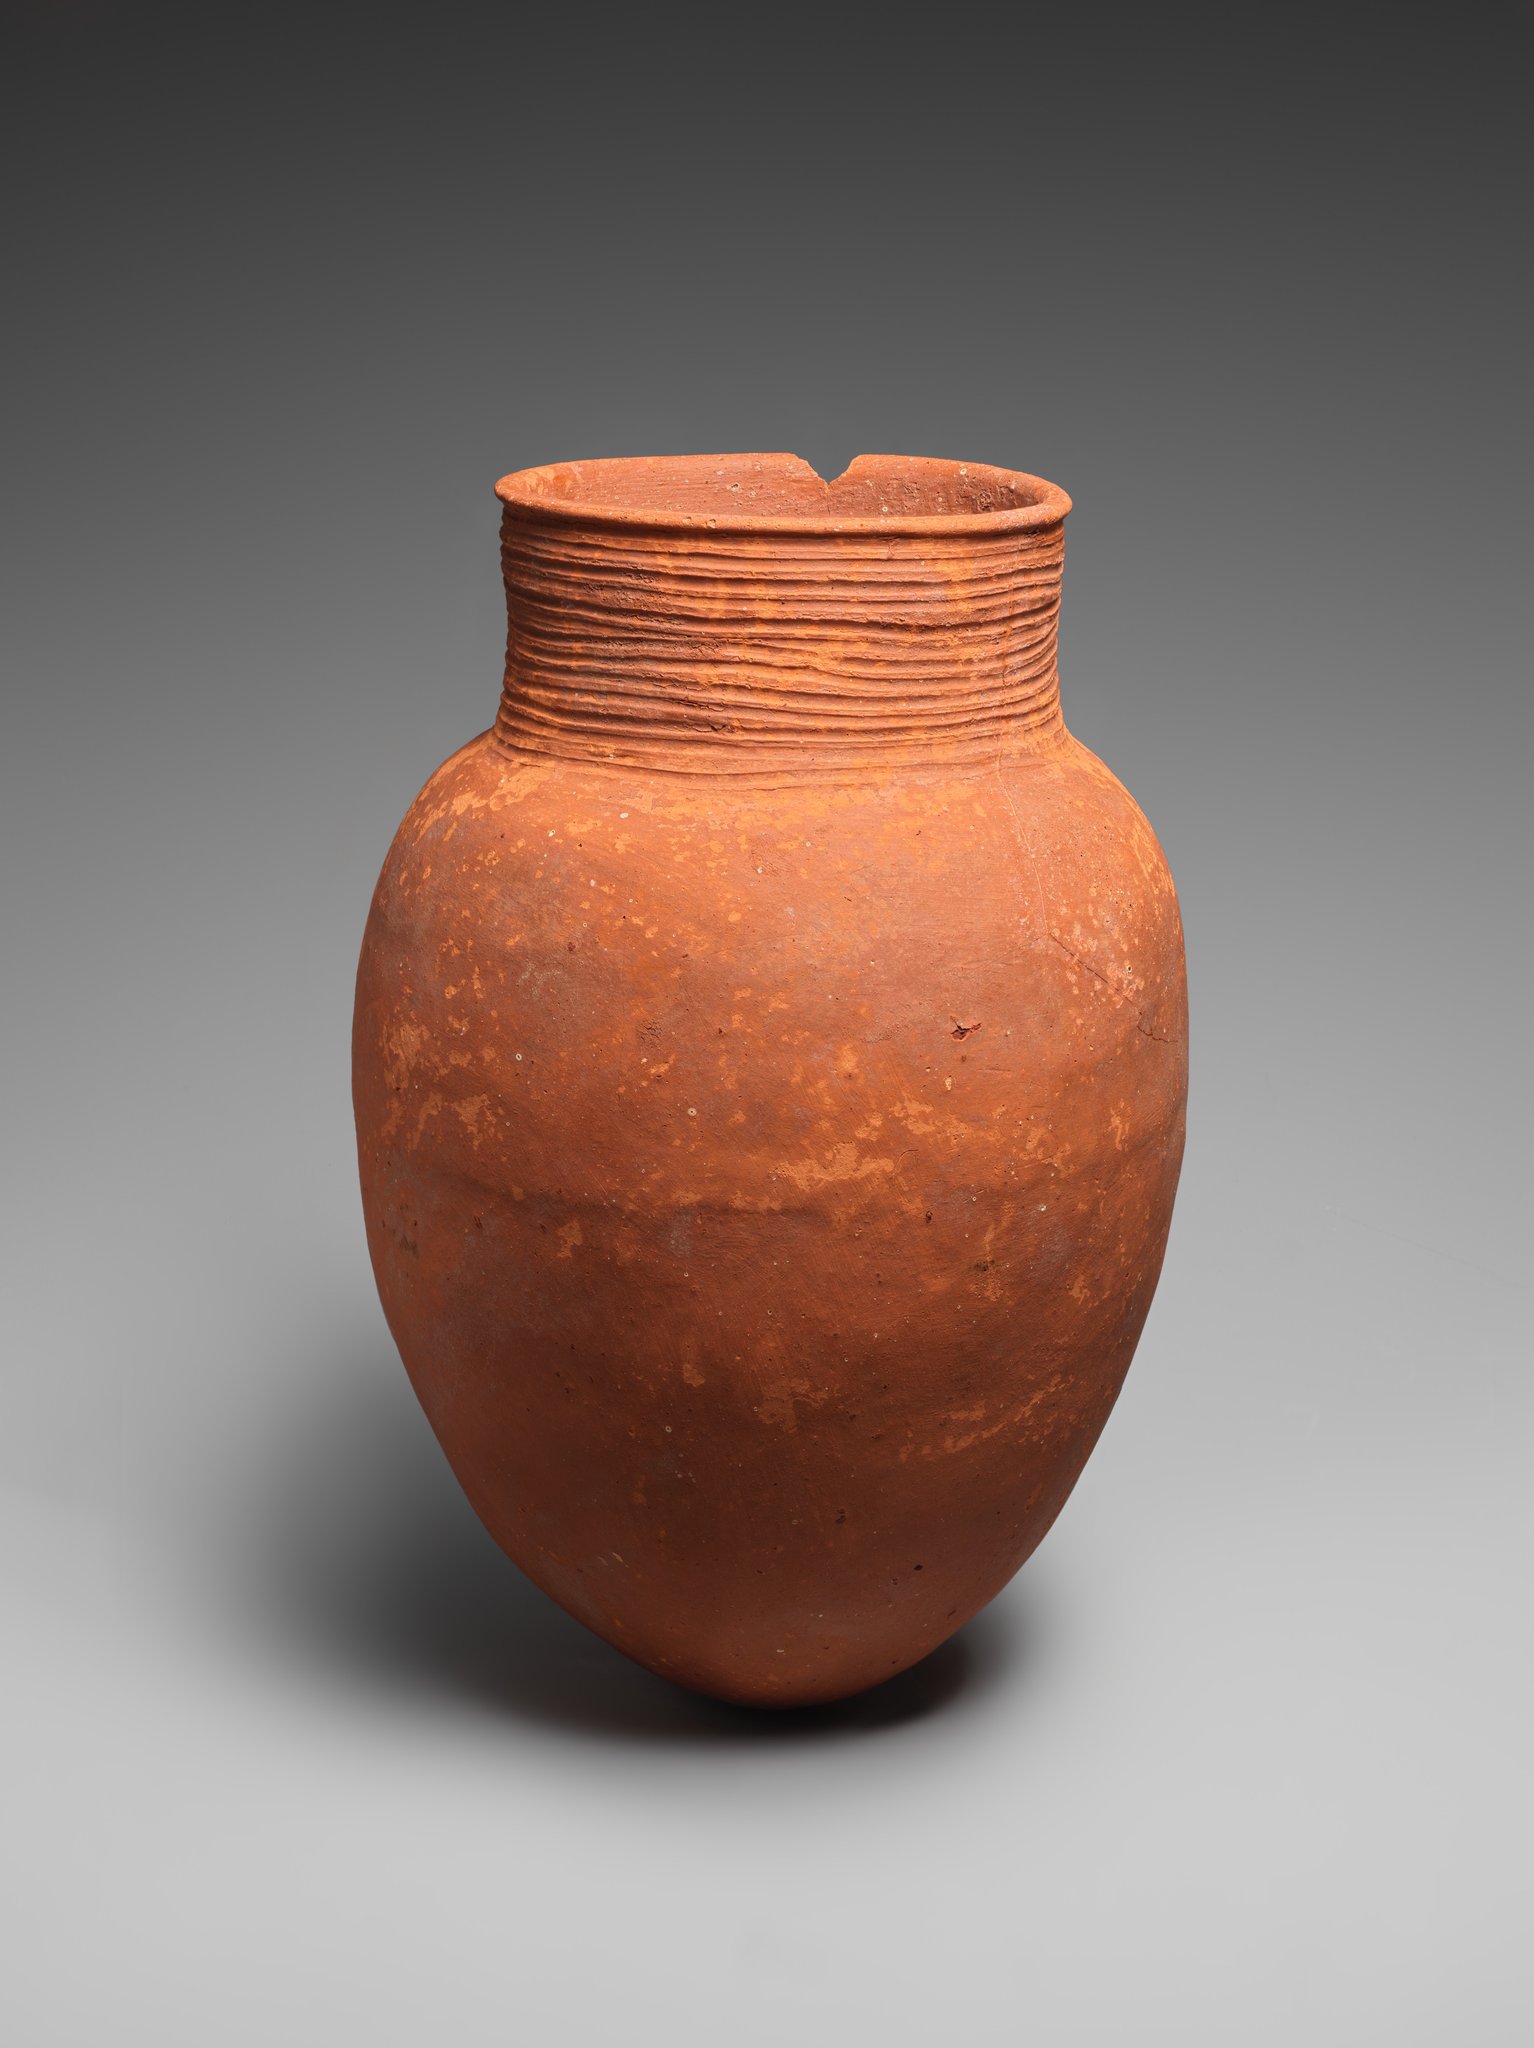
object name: vessel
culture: dilmun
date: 3000-2001 BCE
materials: ceramic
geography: bahrain (ancient dilmun)